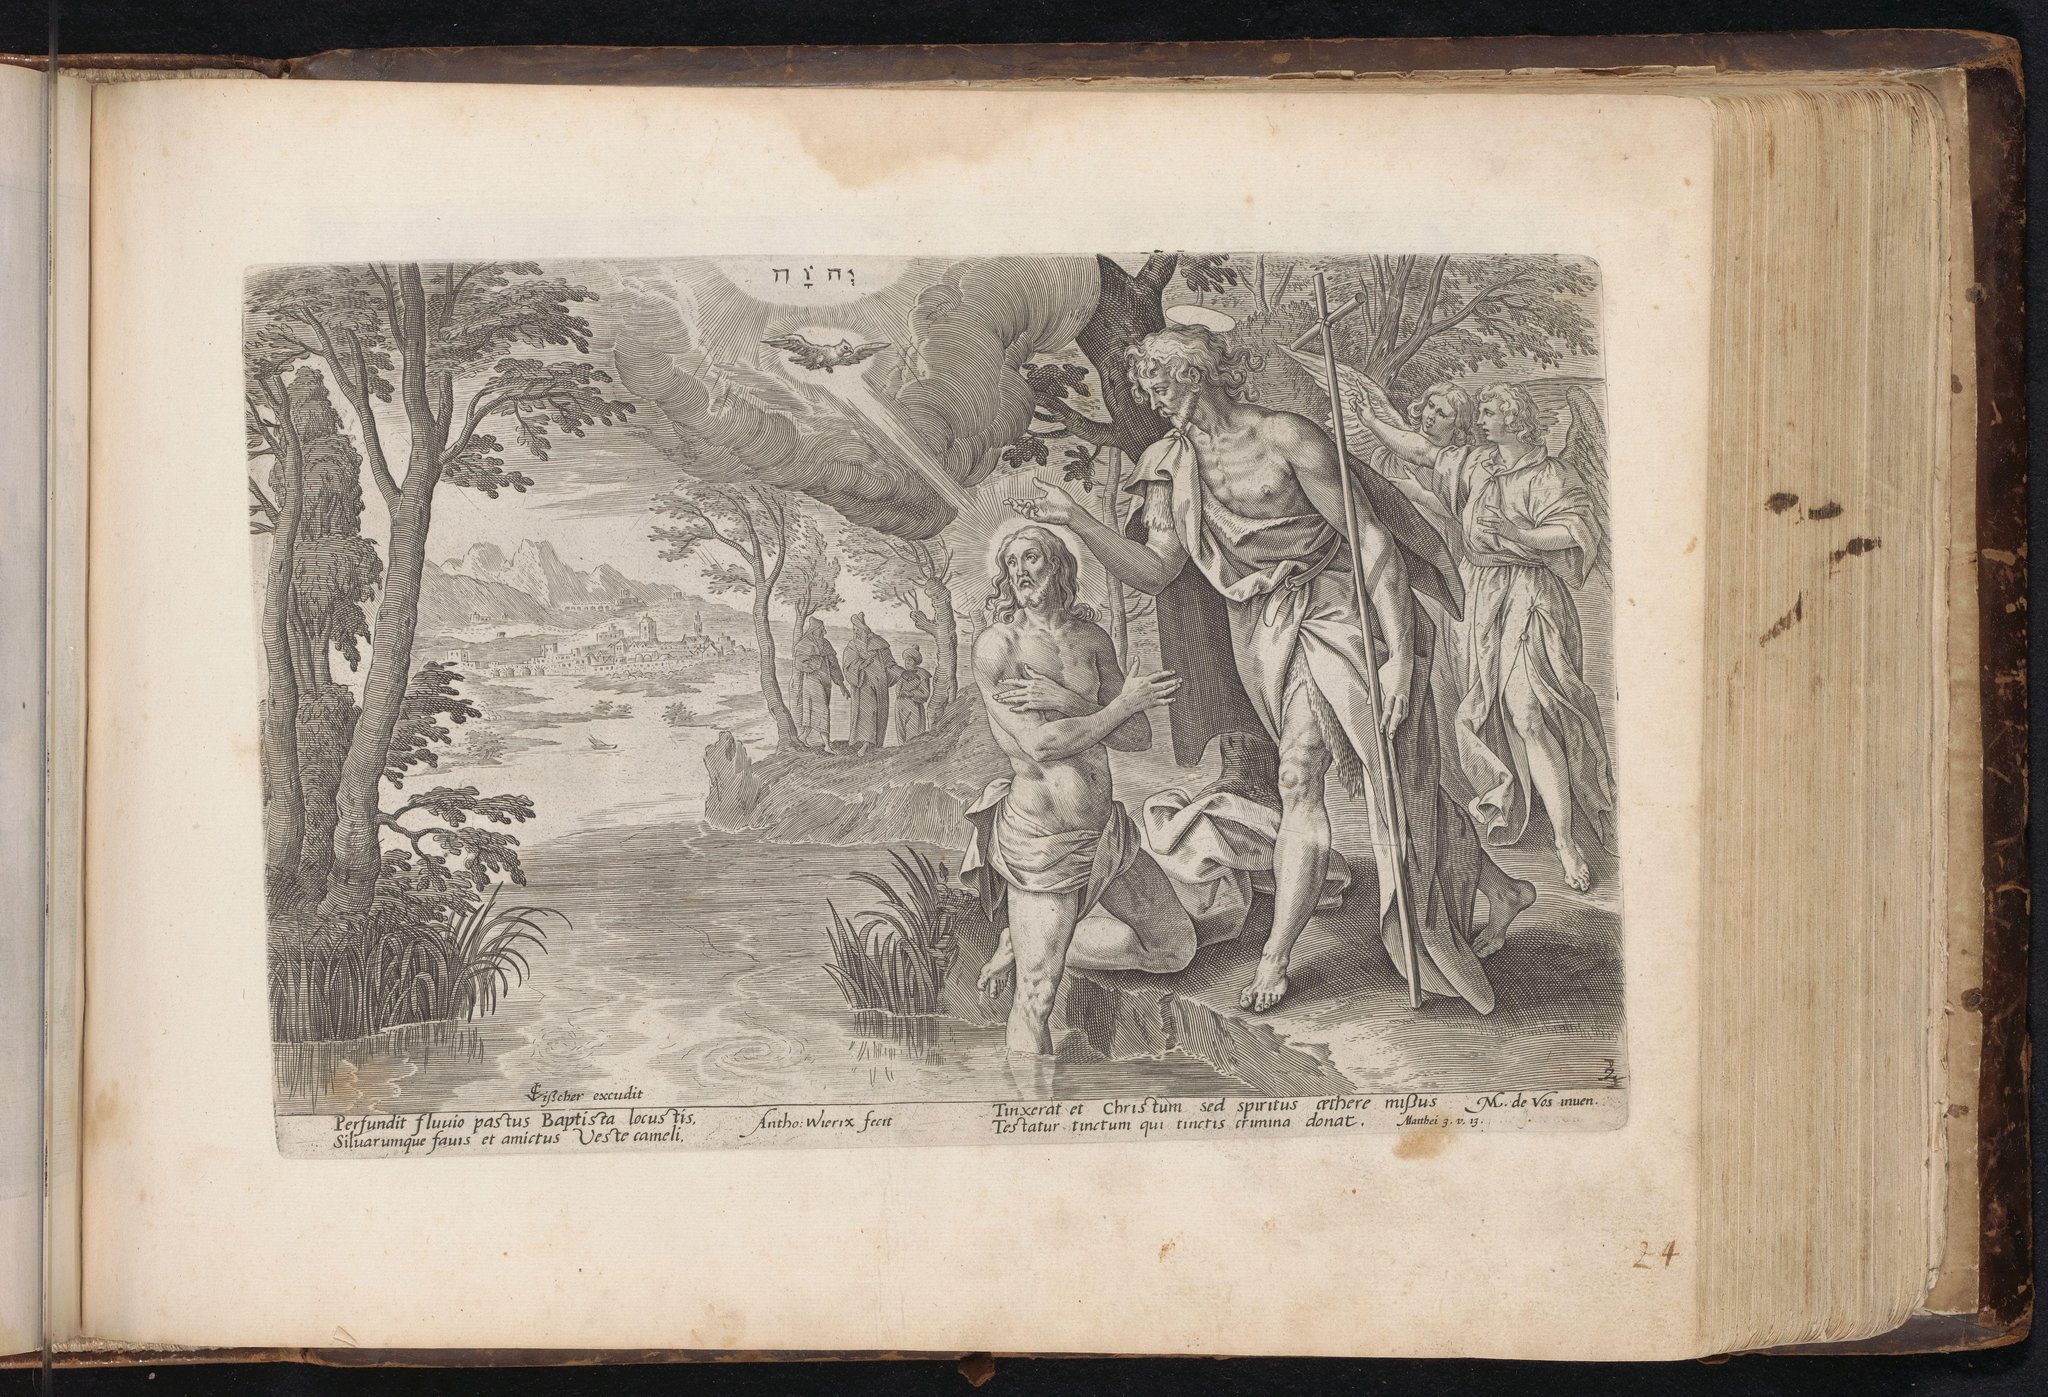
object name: print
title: Van het Doopsel en Bekooringh Christi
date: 1584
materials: paper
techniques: engraving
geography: alkmaar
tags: baptism of christ in the river jordan: john the baptist pouring out water on christ's head: the holy ghost descends, tetragram (in roman or hebrew script) ~ symbol of god the father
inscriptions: serial number: ‘3’, number: ‘24’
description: Christus wordt gedoopt door Johannes de Doper en de Heilige Geest daalt als een duif op hem neer. Twee engelen kijken rechts toe. Onder de voorstelling een verwijzing in het Latijn naar de Bijbeltekst in Mat. 3:13. Deze prent maakt deel uit van een album.